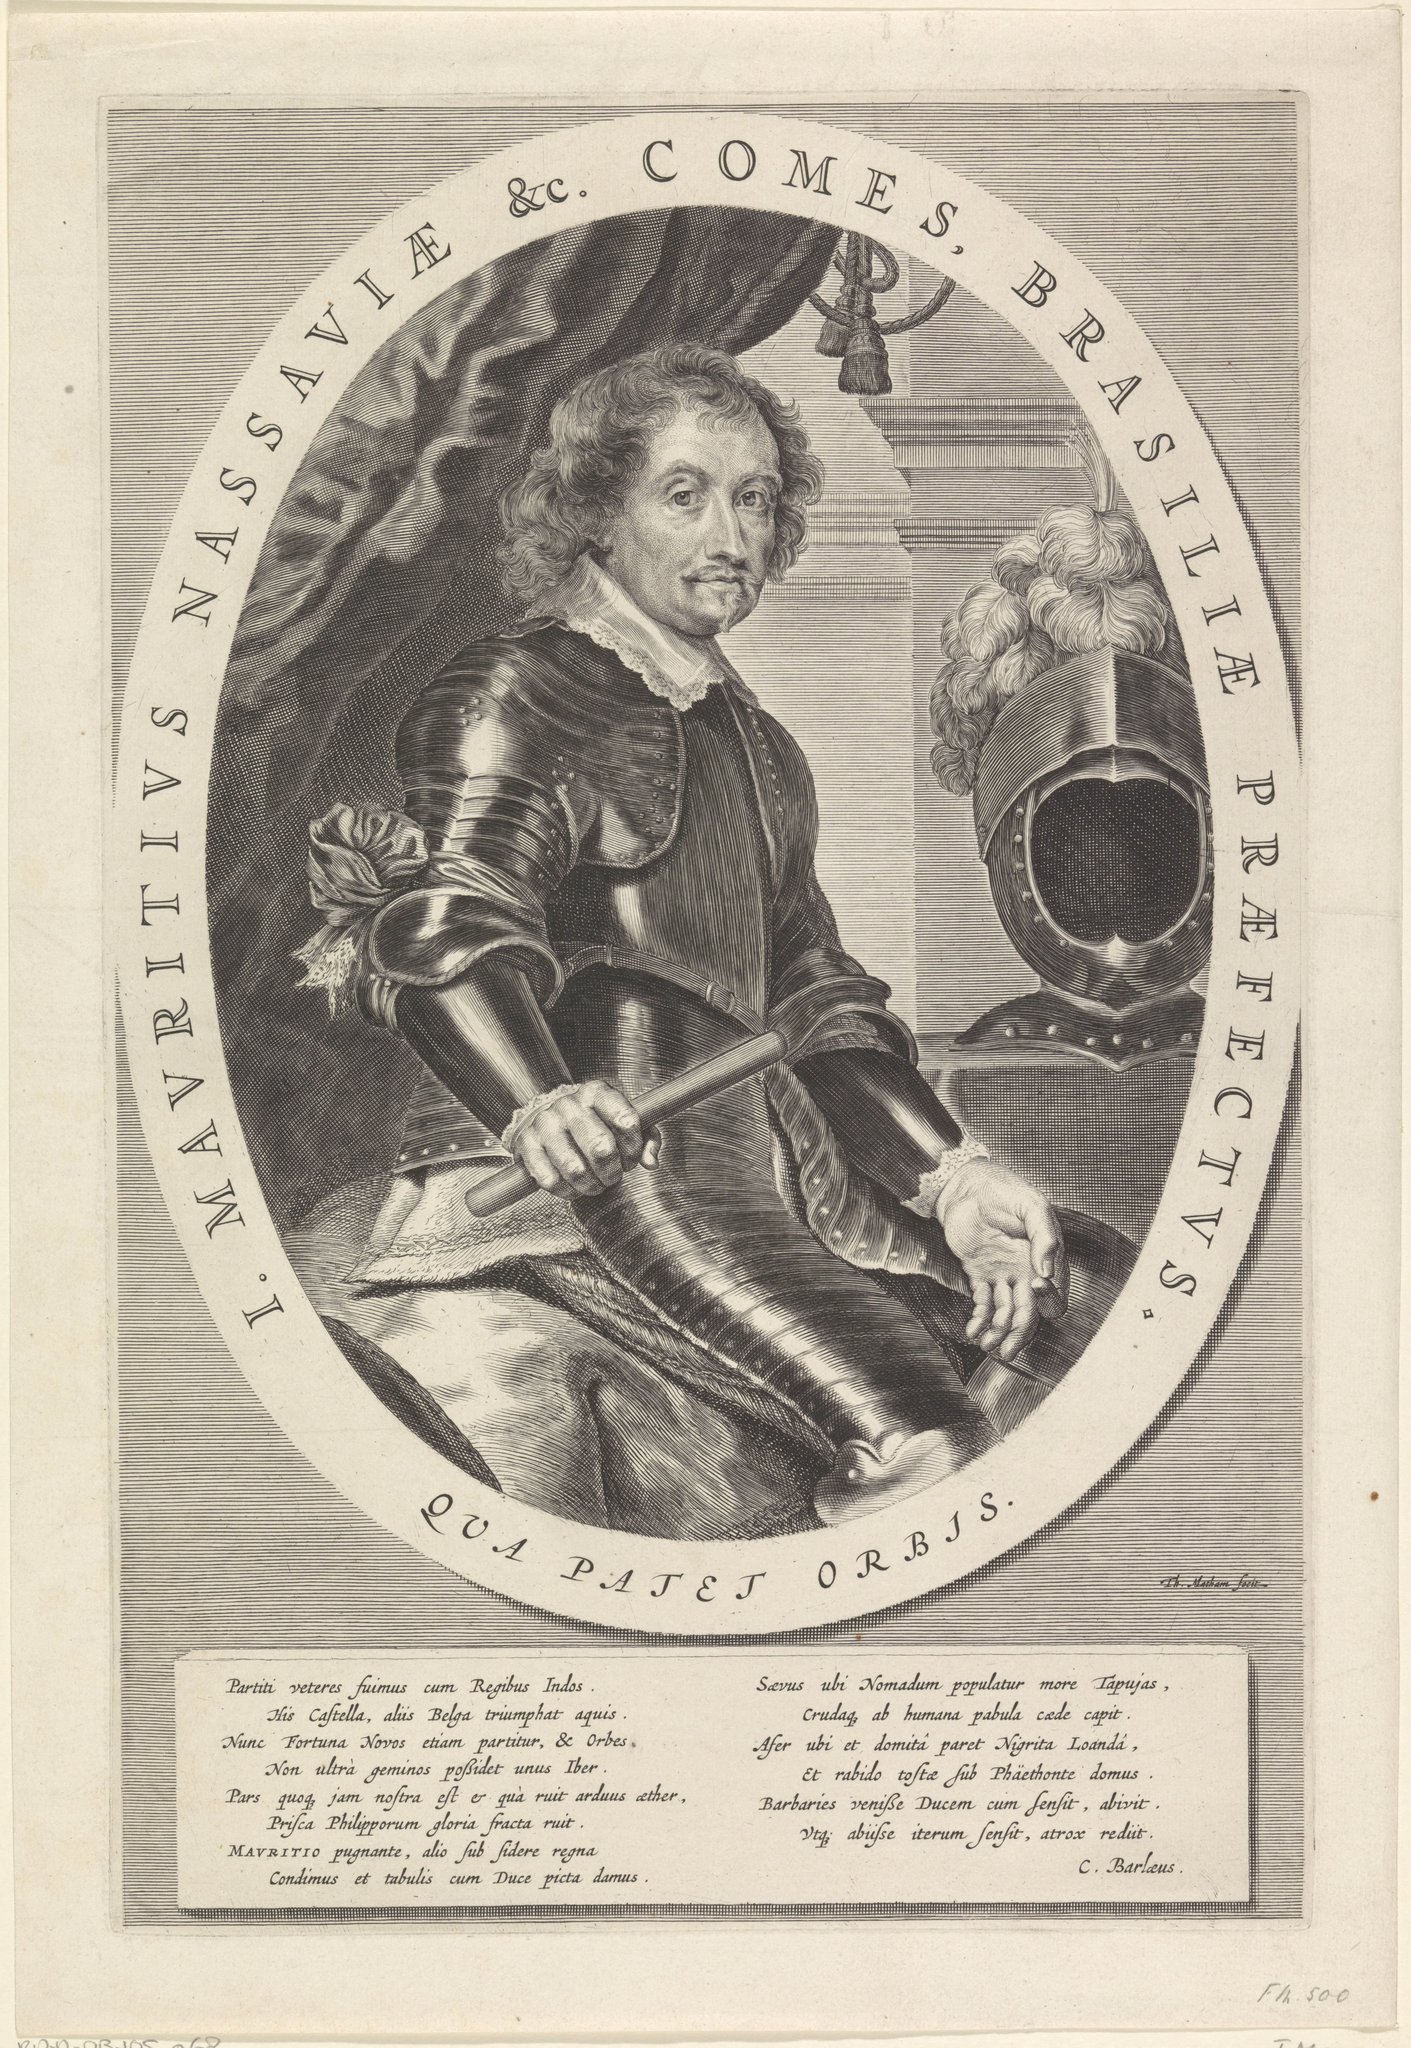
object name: print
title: Portret van Johan Maurits, graaf van Nassau-Siegen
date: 1621-1676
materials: paper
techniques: engraving, etching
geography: northern netherlands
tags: earl, johan maurits graaf van nassau-siegen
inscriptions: collector's mark: Lugt 240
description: Portret van Johan Maurits in een ovaal met randschrift. In zijn rechterhand een commandostaf. Rechts een helm. In een kader twee kolommen met veertien regels Latijnse tekst.